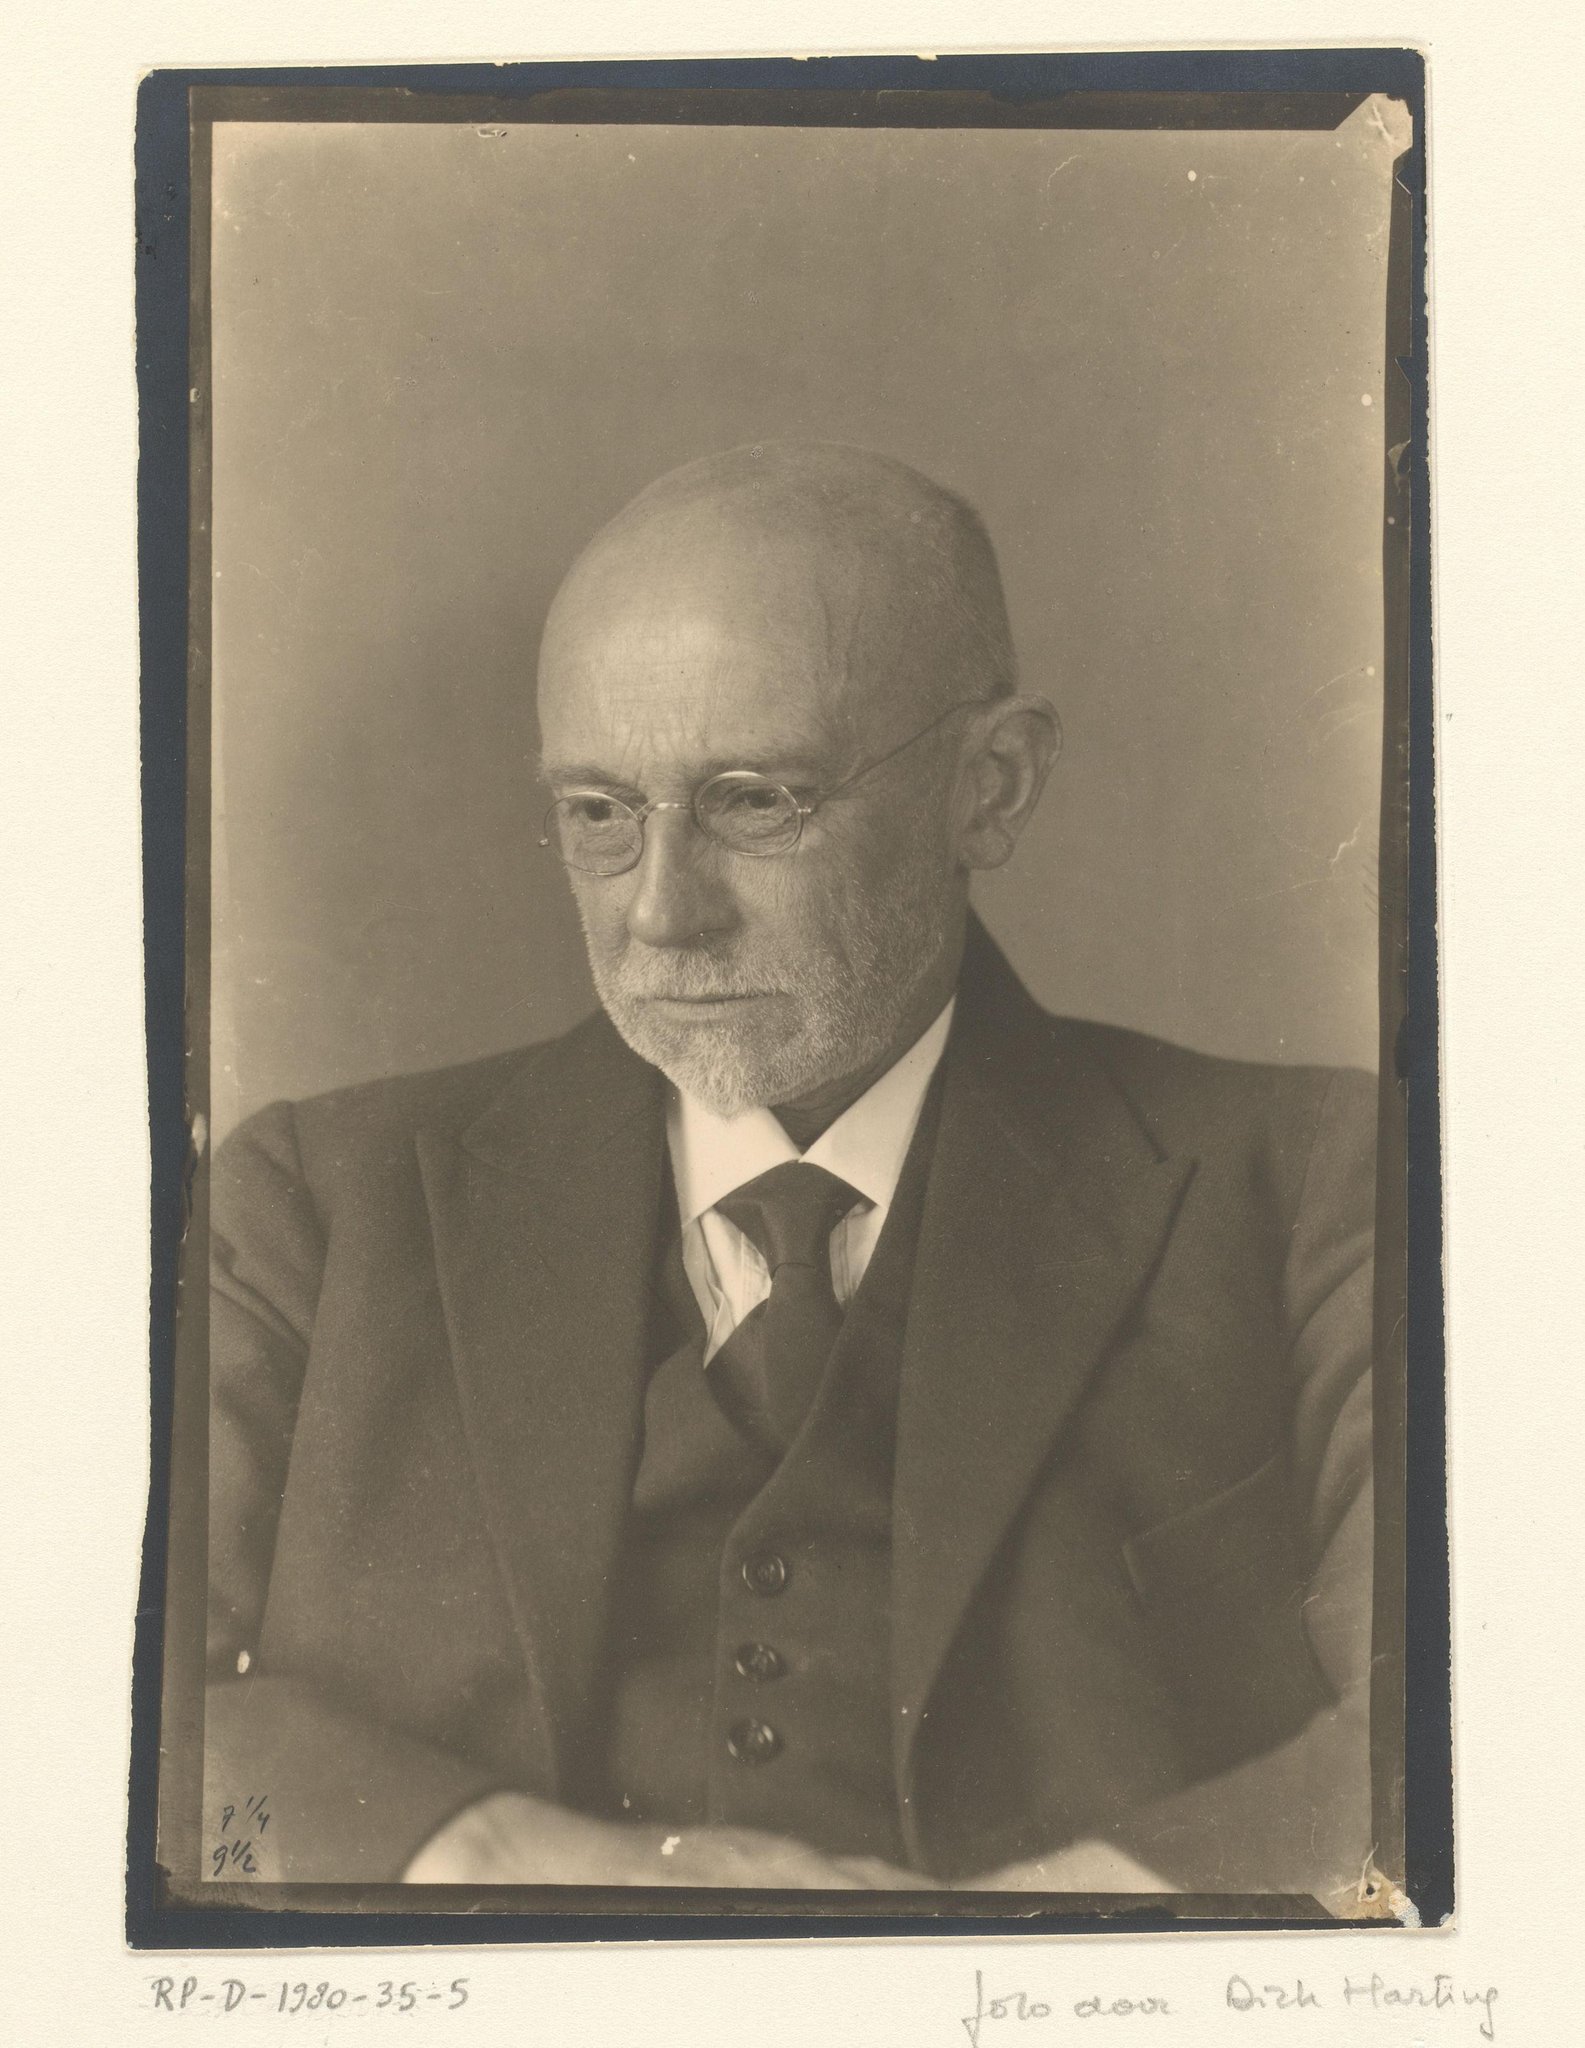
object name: photograph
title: Portret van Maurits van der Valk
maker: dirk harting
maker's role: painter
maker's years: 1884-1970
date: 1910-1930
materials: paper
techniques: gelatin silver print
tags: print maker, draughtsman, maurits van der valk, historical persons, portrait, self-portrait of graphic artist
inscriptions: inscription: ‘7 1/4/ 9 1/2’, collector's mark: Lugt 2228a, inscription: ‘M vd Valk’